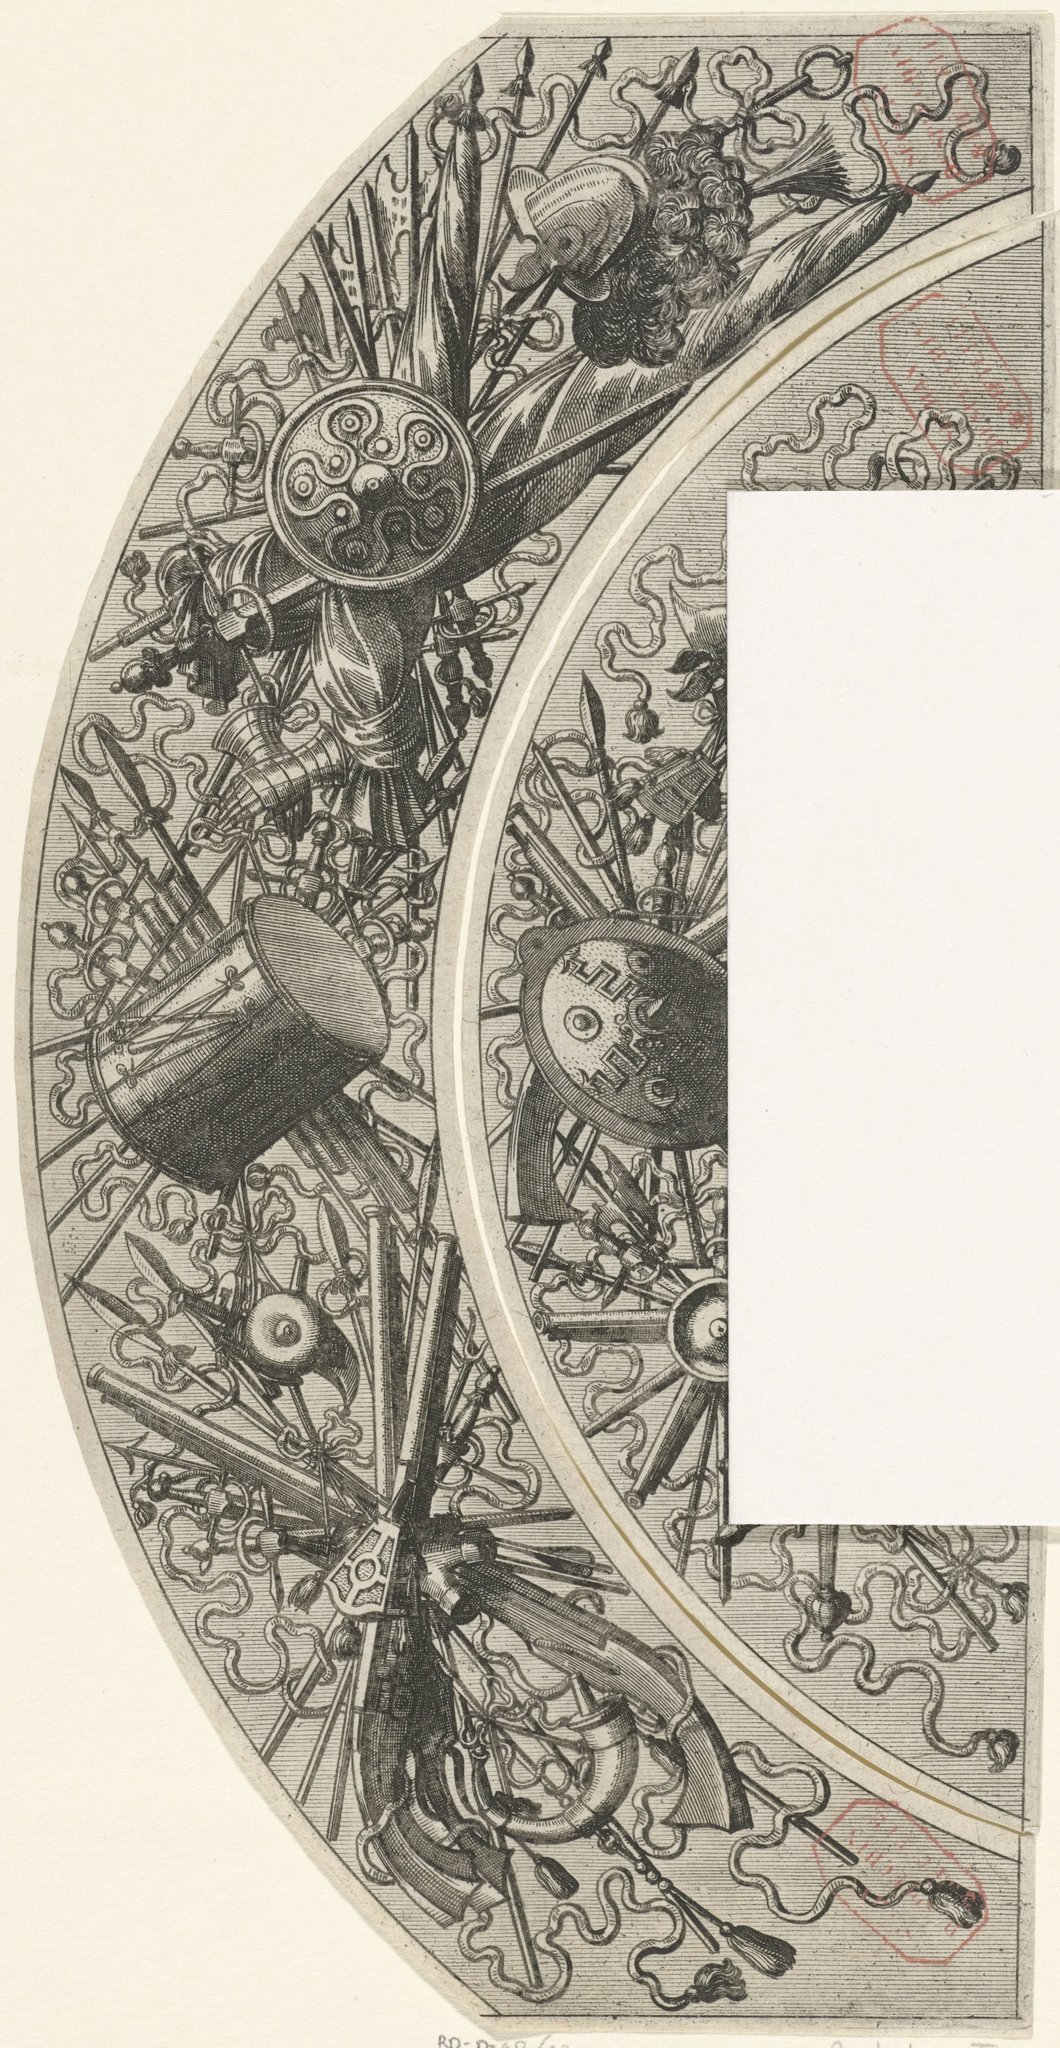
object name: print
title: Panoplia sev armamentarium…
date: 1572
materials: paper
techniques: etching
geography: netherlands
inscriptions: collector's mark: Lugt 2275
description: In de trofee hangen gekruiste vaandels, een trommel en diverse gekruiste wapens. Uit serie, bestaande uit een titelblad en 16 bladen.